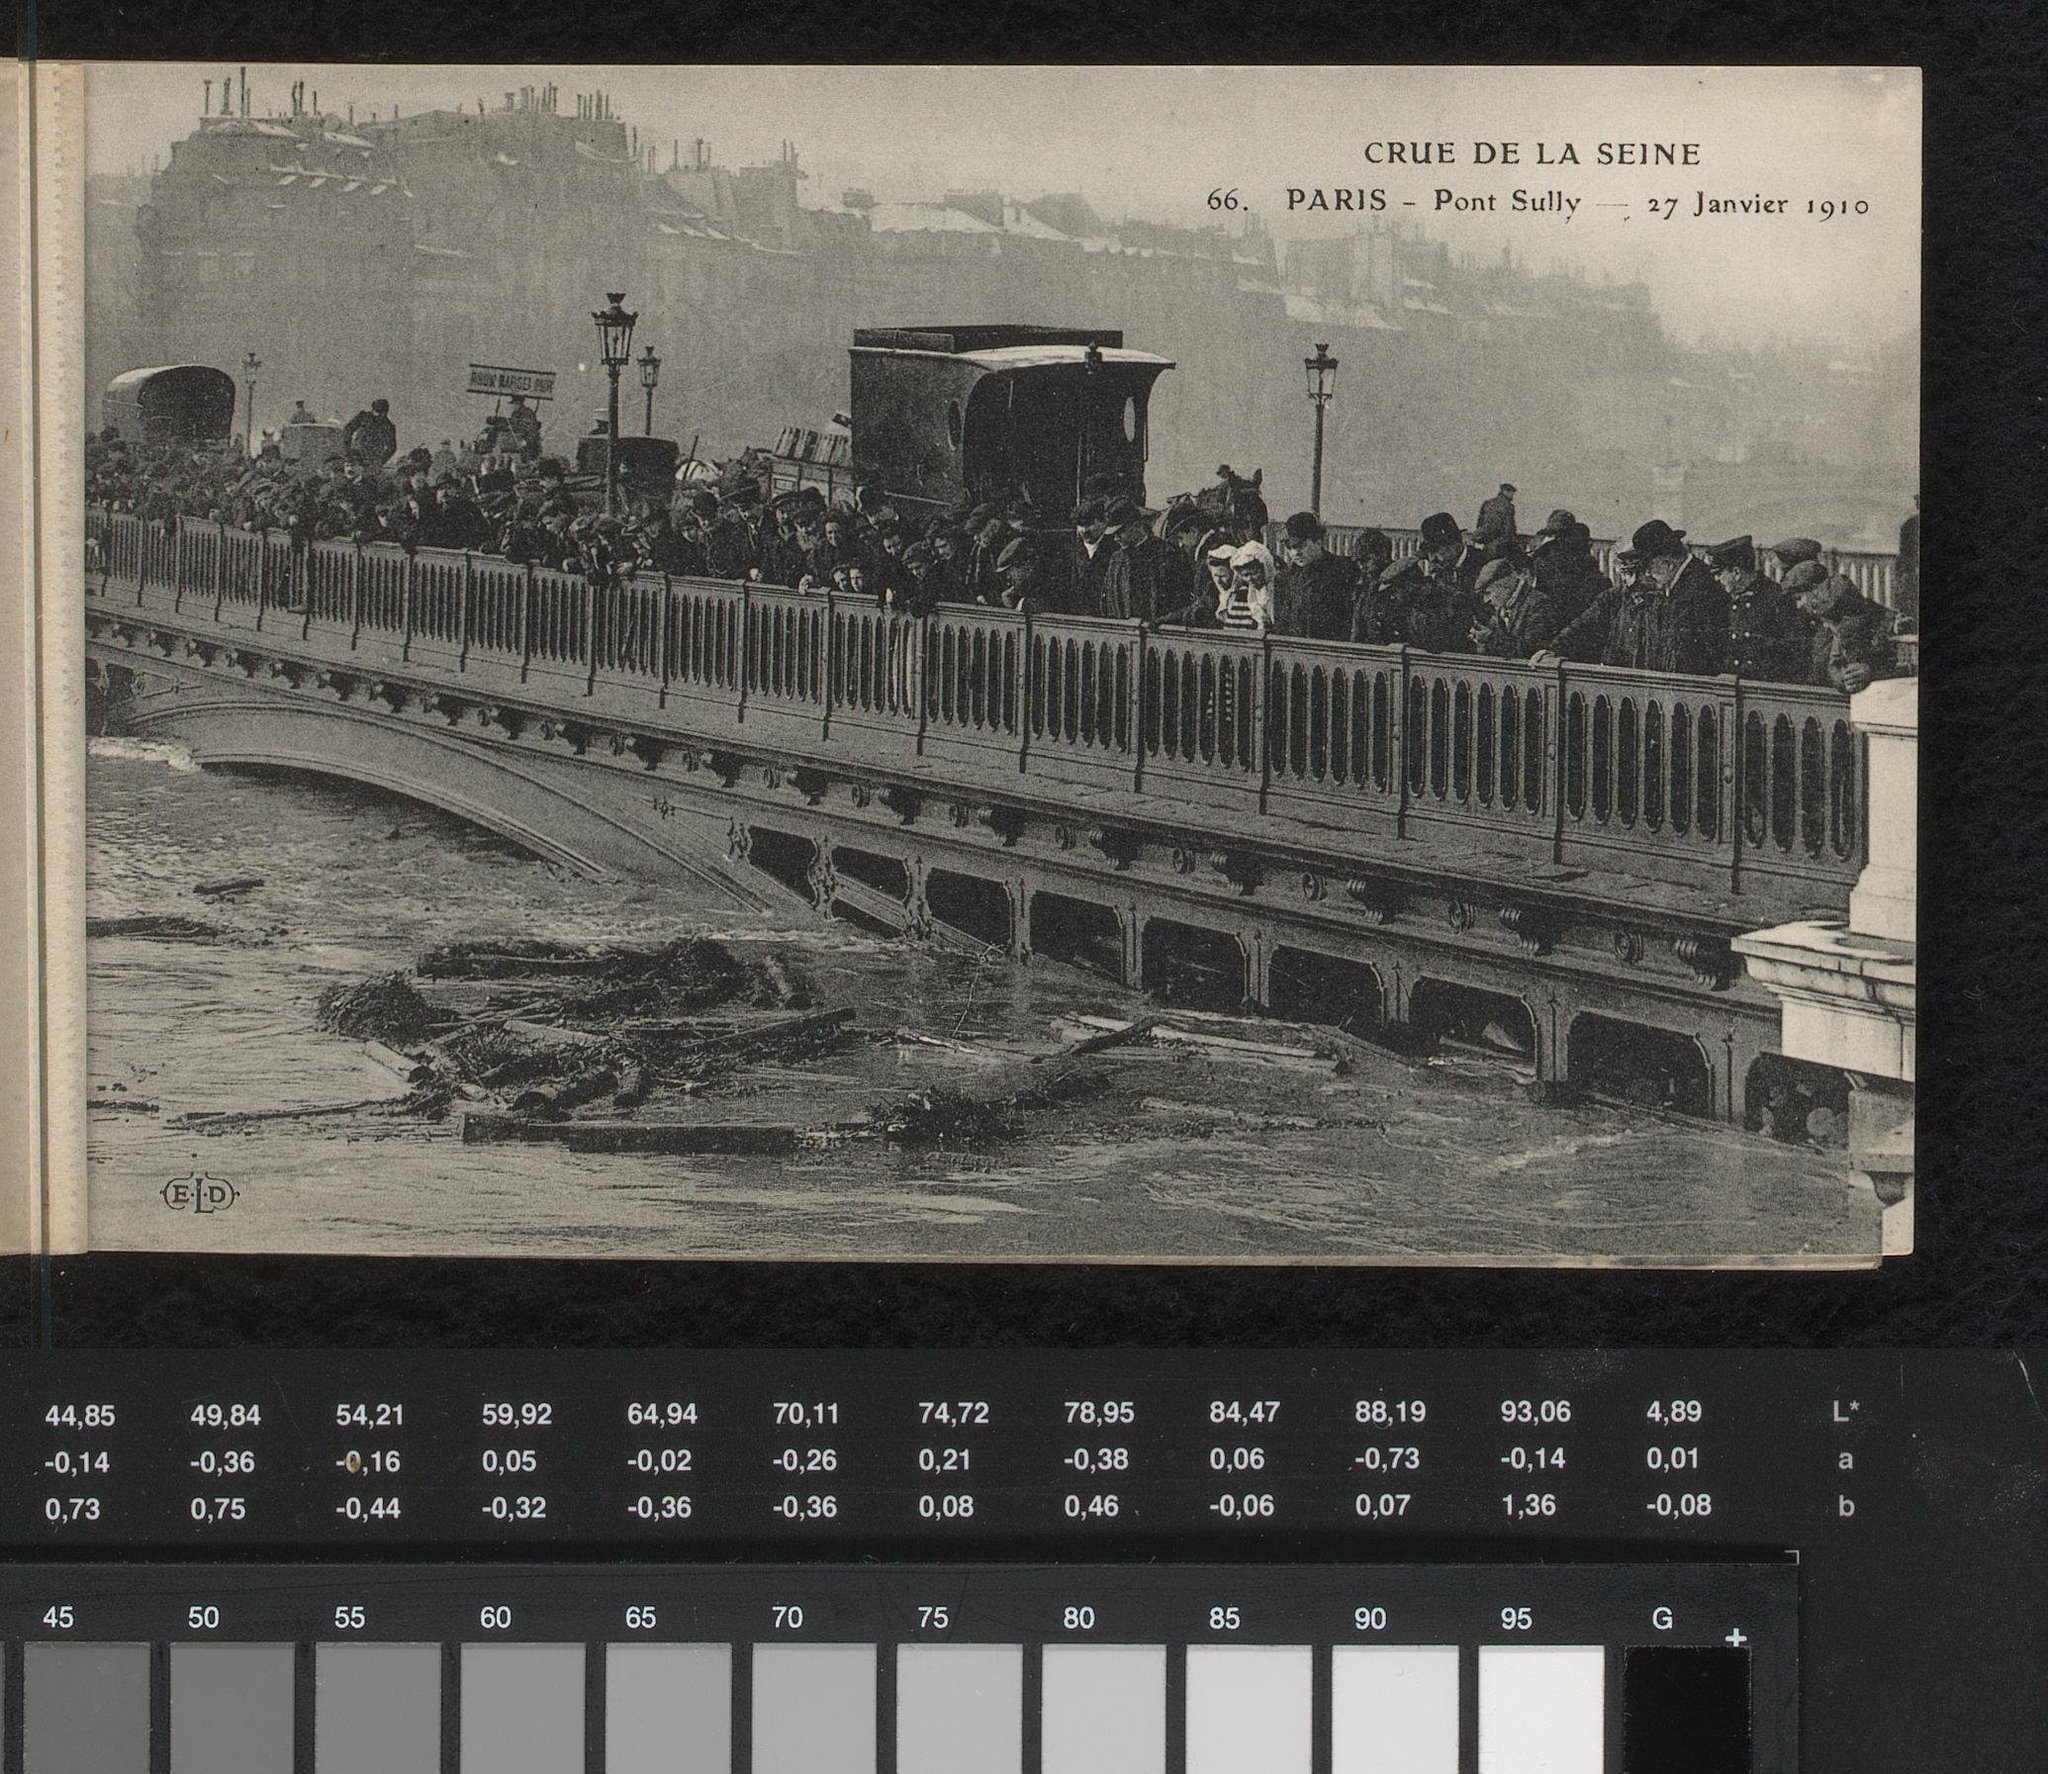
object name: photomechanical print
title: Crue de la Seine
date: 1910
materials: cardboard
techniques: photograph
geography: paris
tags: flood, bridge, city-view, and landscape with man-made constructions (+ city(-scape) with figures, staffage), paris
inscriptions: date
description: Prentbriefkaart maakt deel uit van een album.